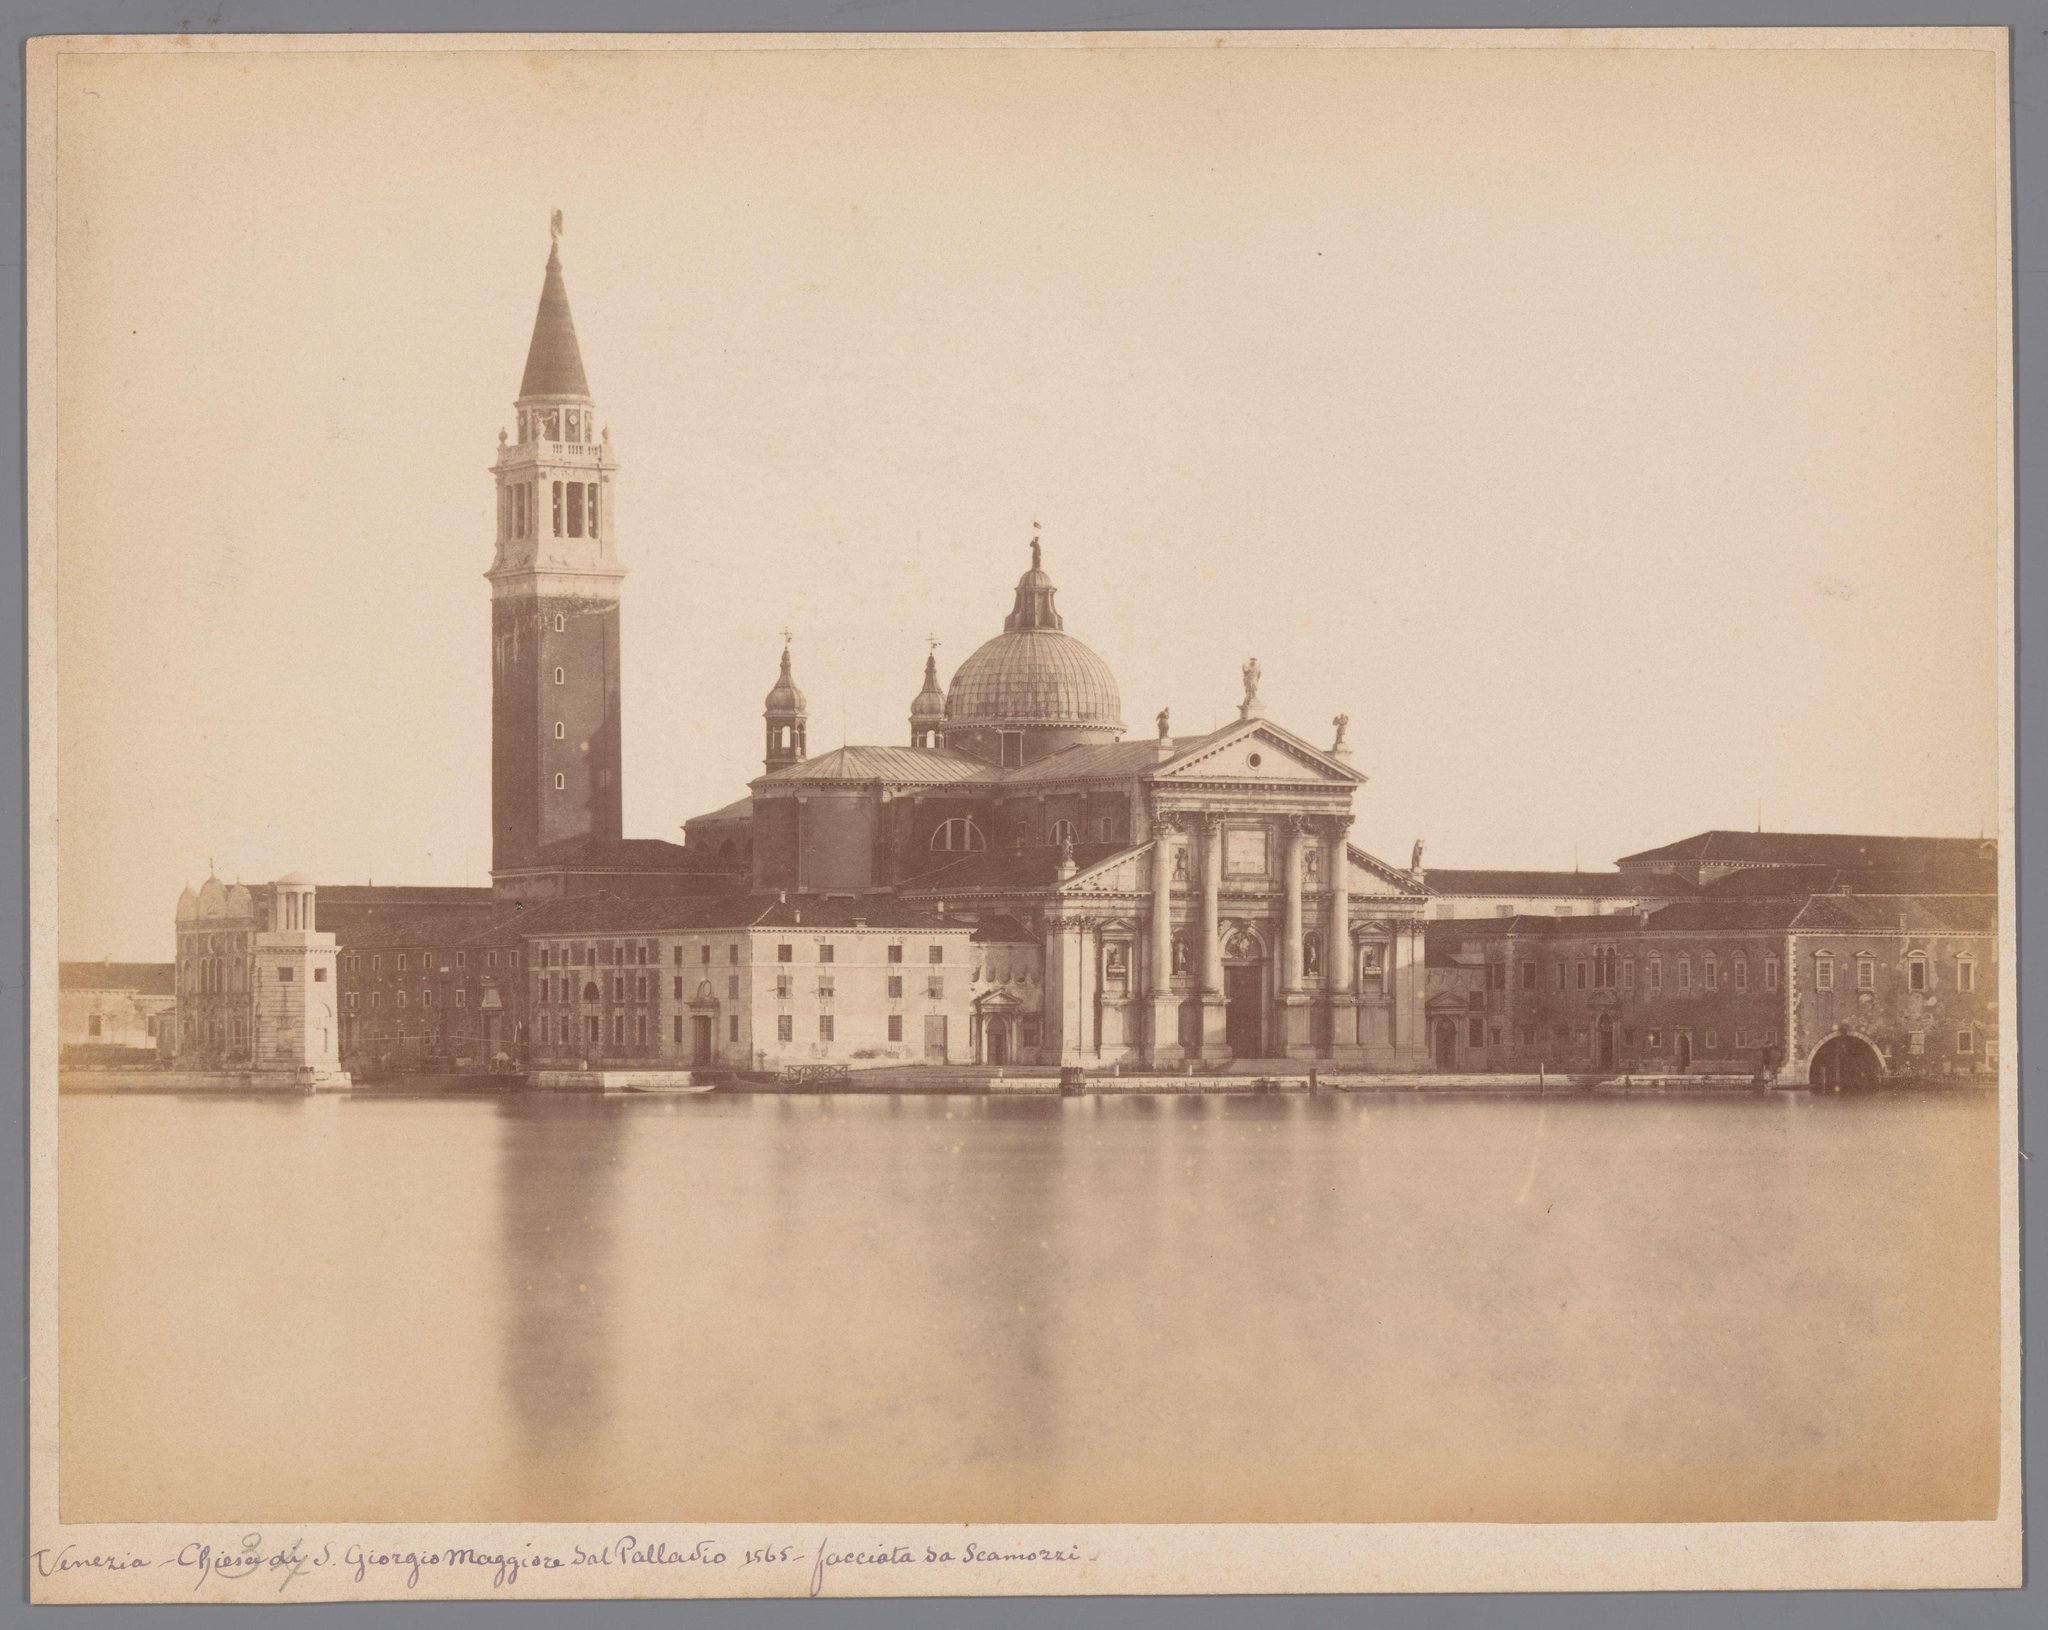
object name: photograph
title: Venezia - Chiesa di S. Giorgio Maggiore dal Palladio 1565 - facciata da Scamozzi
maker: Anonymous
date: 1851-1900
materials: cardboard, paper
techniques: albumen print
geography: venice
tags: parts of church exterior and annexes: campanile, church (exterior)